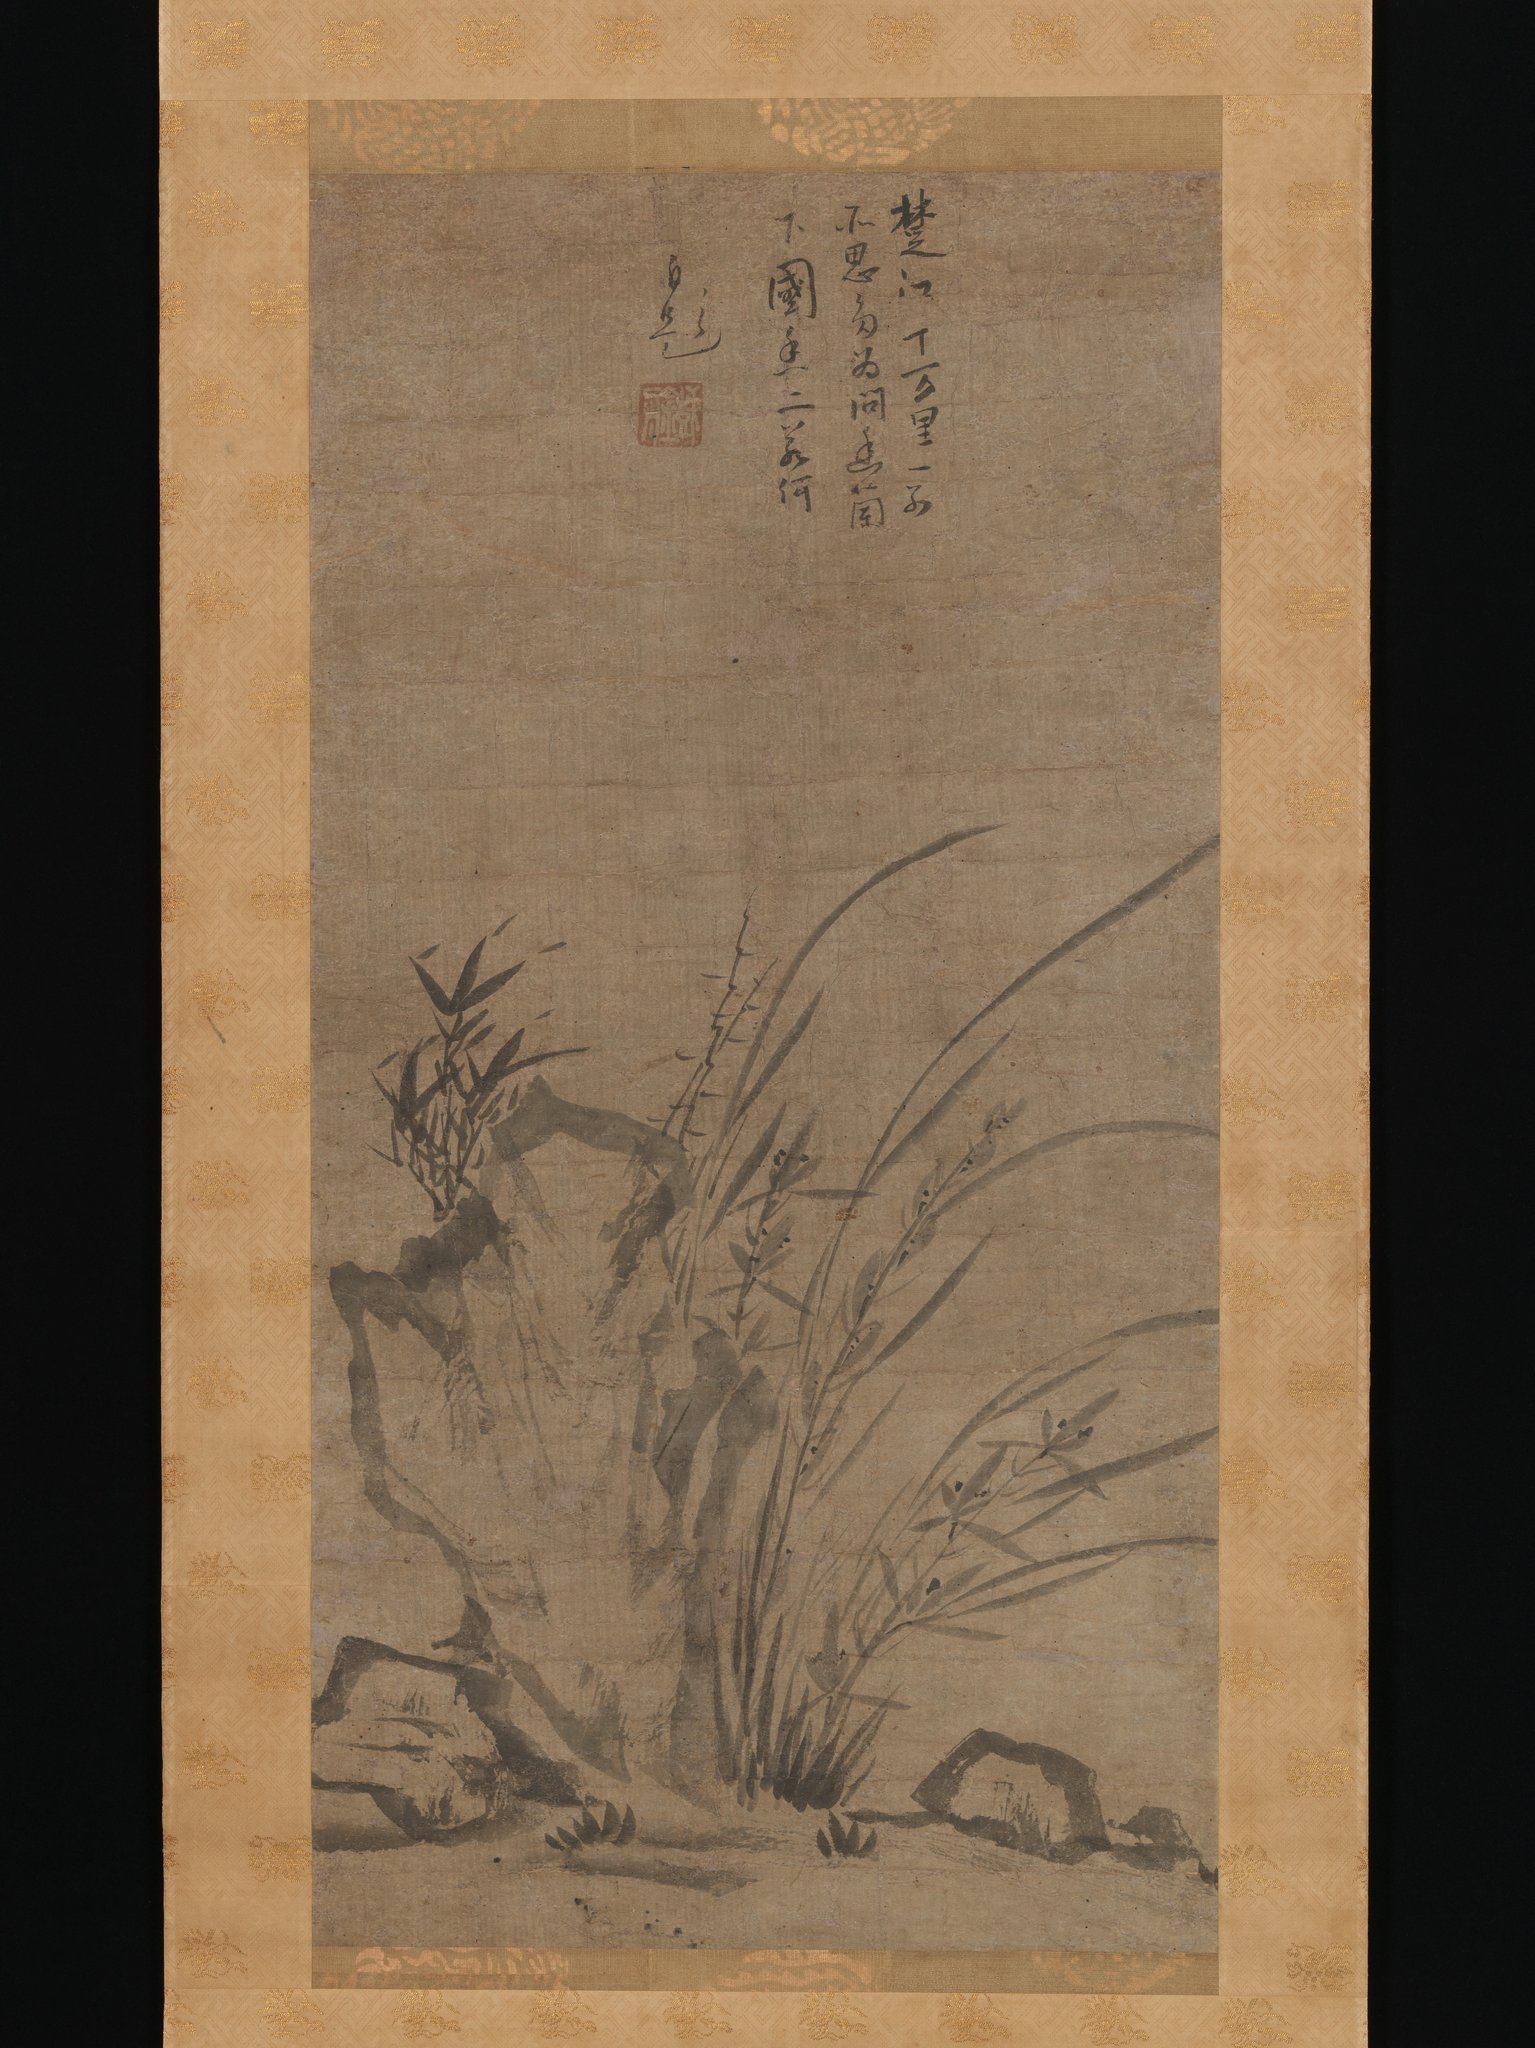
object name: hanging scroll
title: Orchids, Bamboo, Briars, and Rocks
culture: japanese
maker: tesshū tokusai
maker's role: artist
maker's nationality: japanese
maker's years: 1342-1366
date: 1334-1366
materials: ink, paper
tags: orchids,bamboo